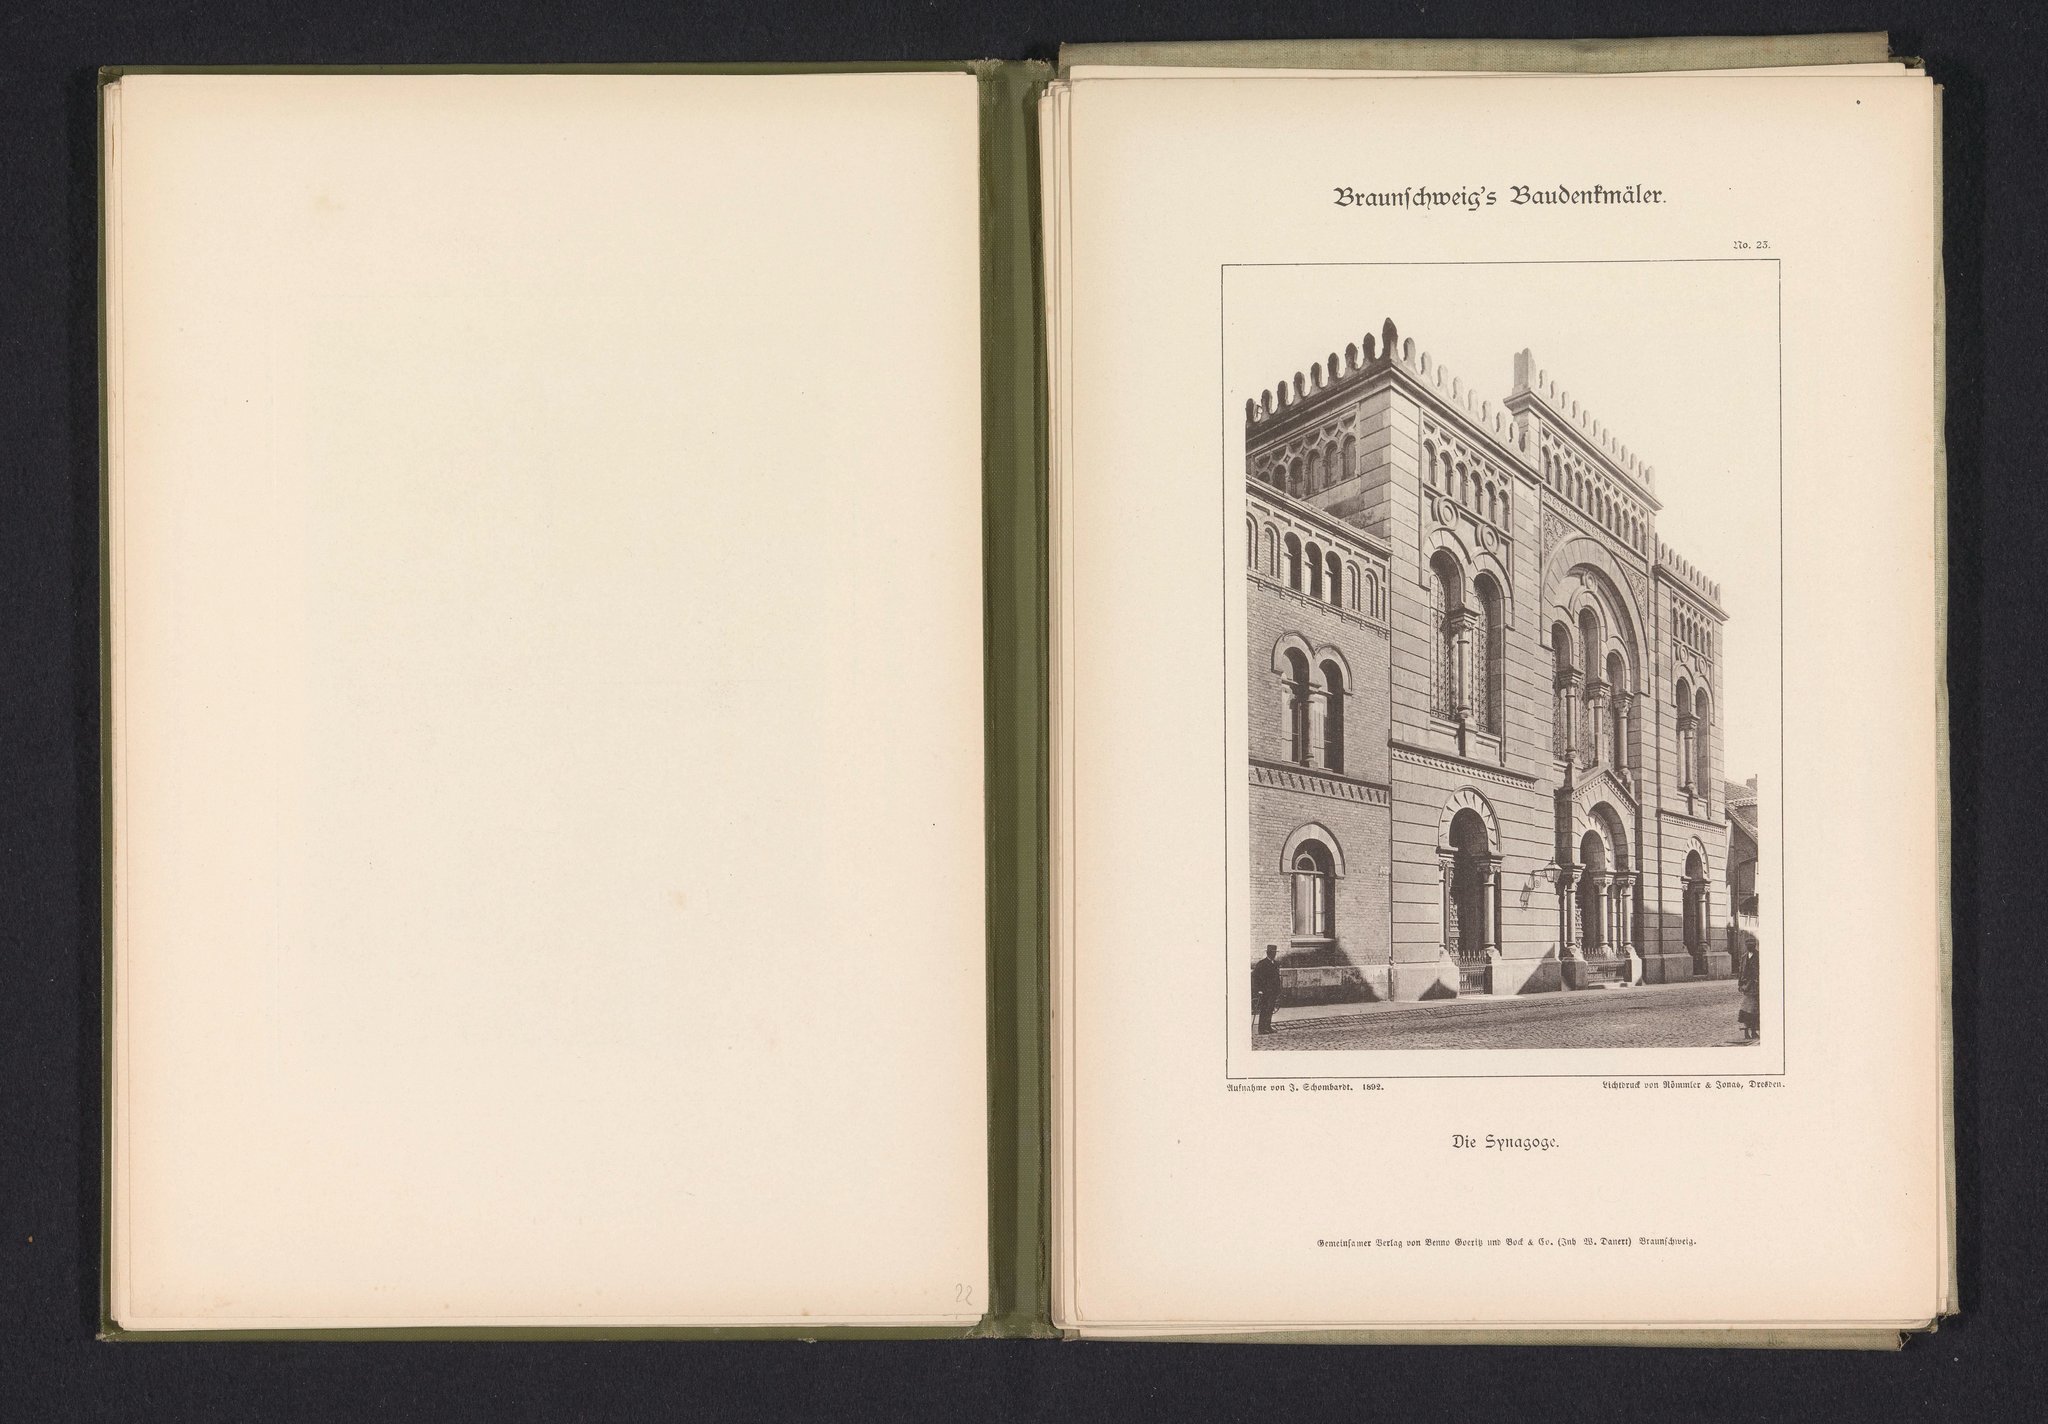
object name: page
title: Braunschweig's Baudenkmäler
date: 1892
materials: paper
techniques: photograph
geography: braunschweig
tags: the synagogue (as building and place of worship ~ jewish religion), façade (of house or building)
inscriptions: number: ‘No. 23.’